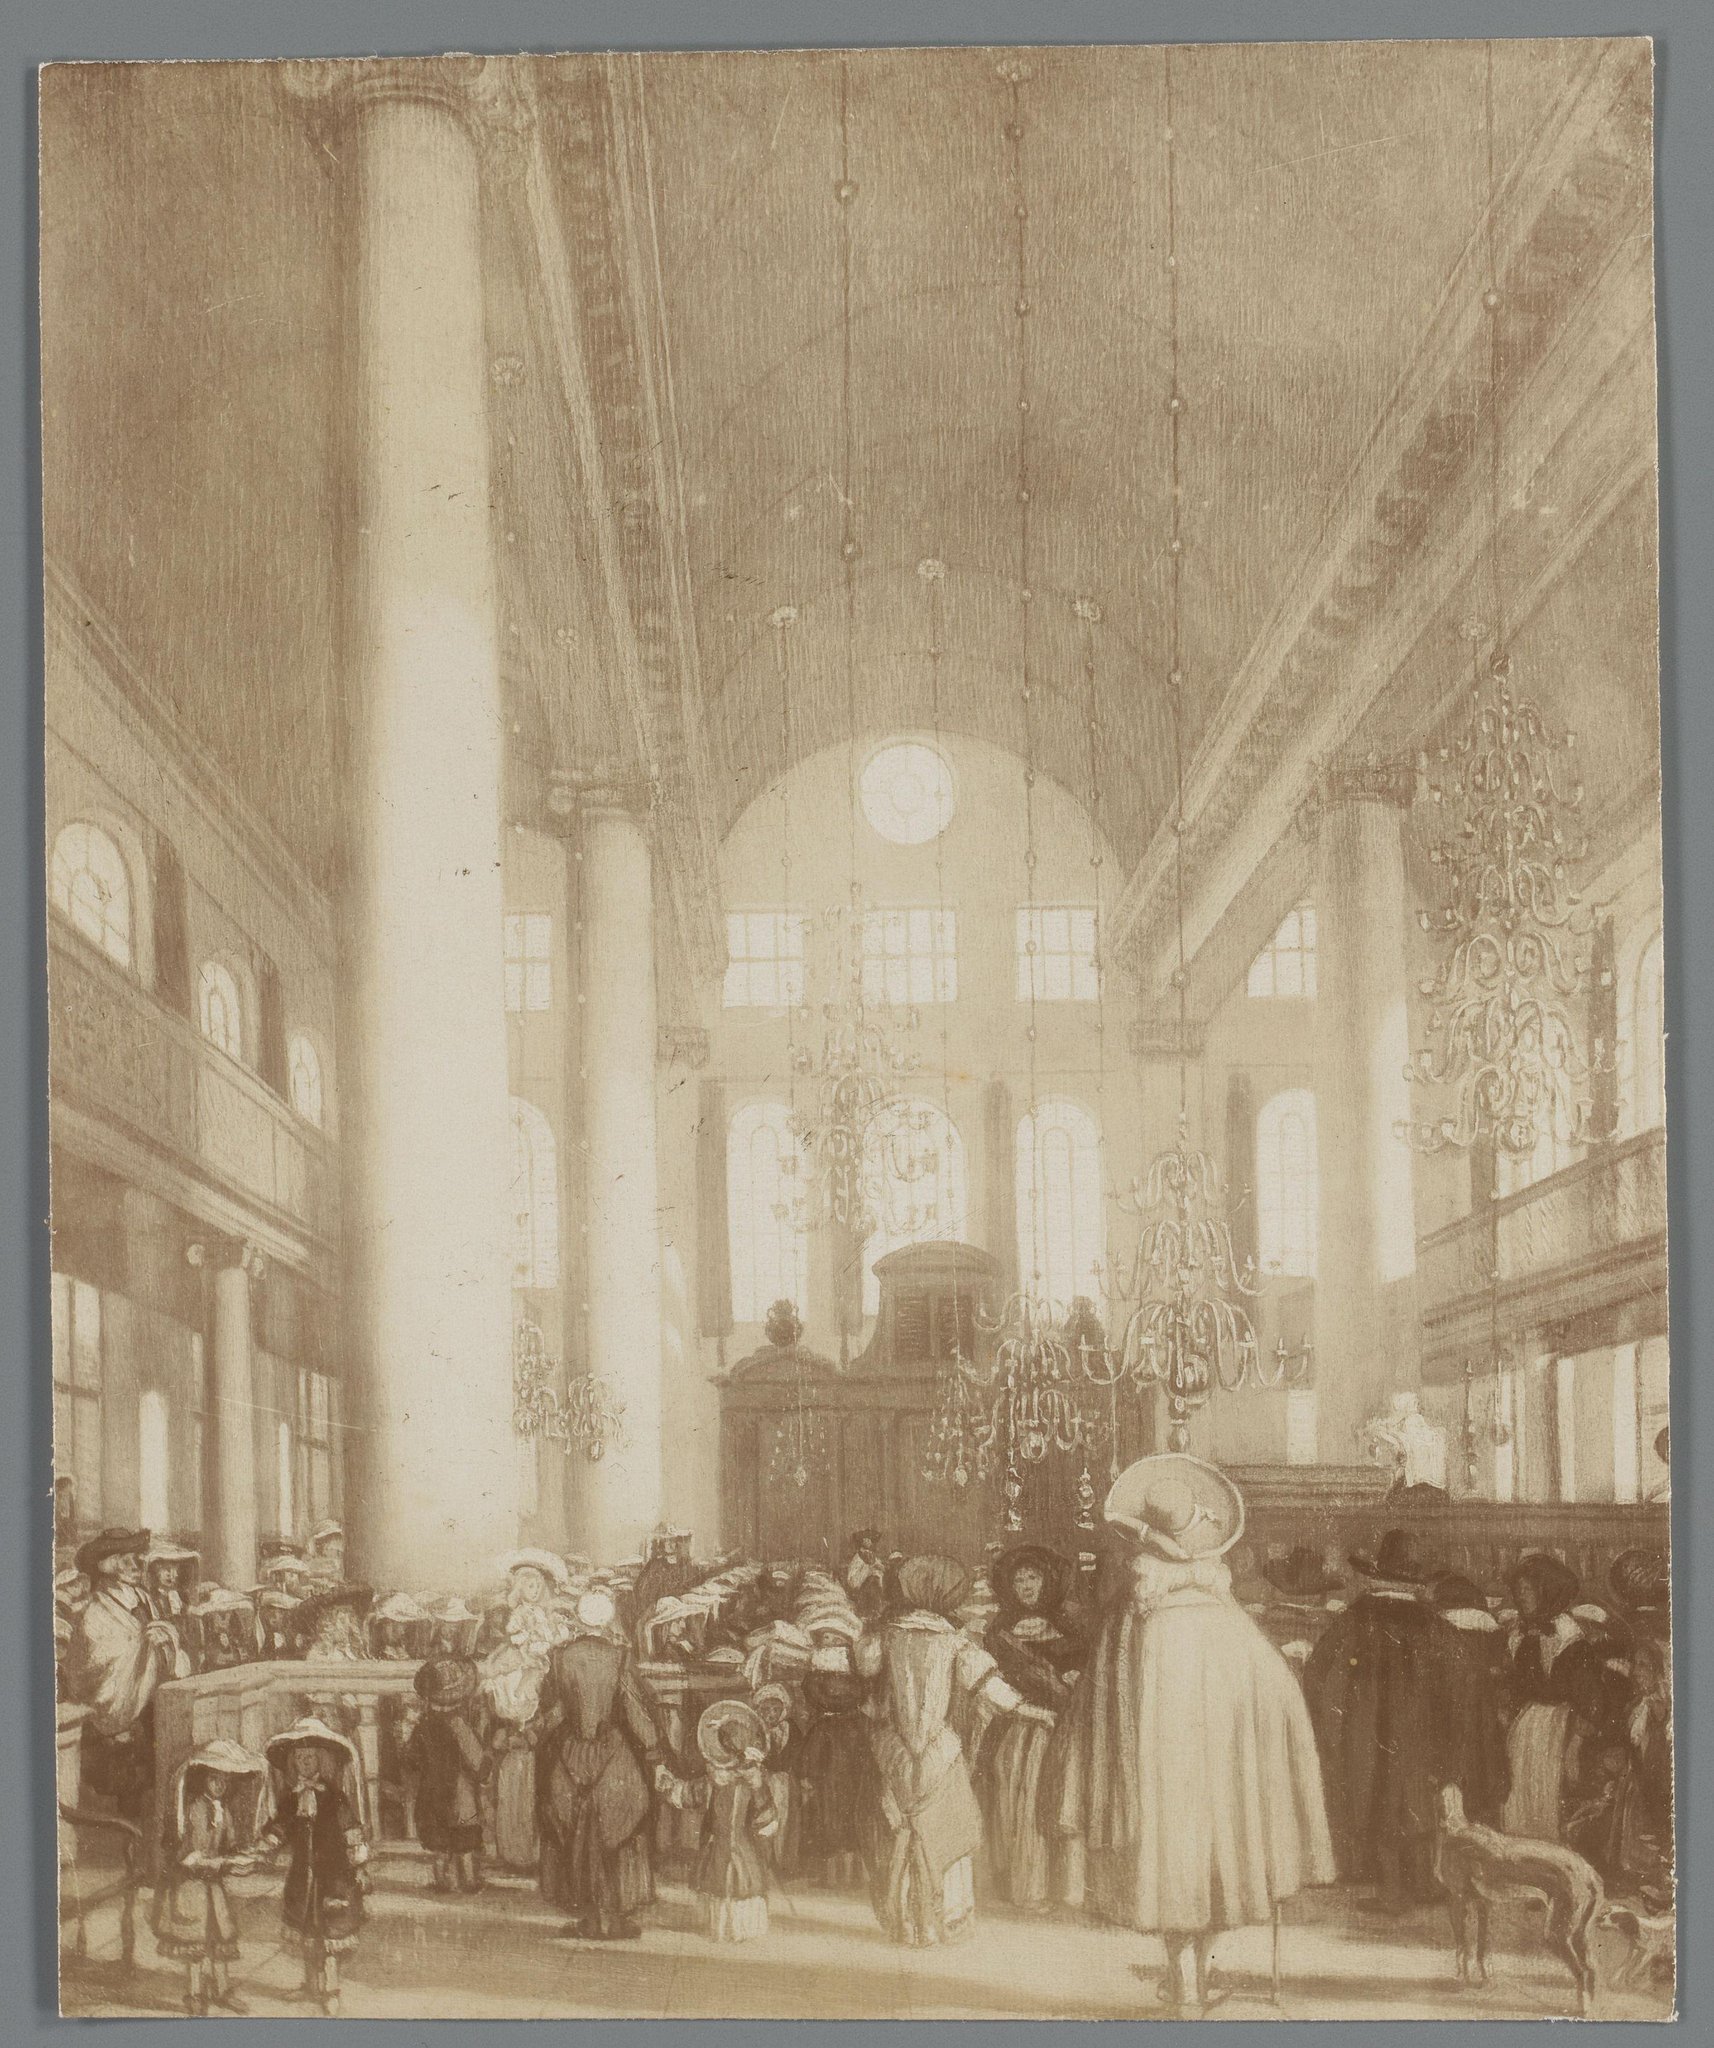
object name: reproduction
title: Fotoreproductie van schilderij van een kerkinterieur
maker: Anonymous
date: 1880-1920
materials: paper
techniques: collodion silver print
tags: interior of church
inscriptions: number: ‘448.’